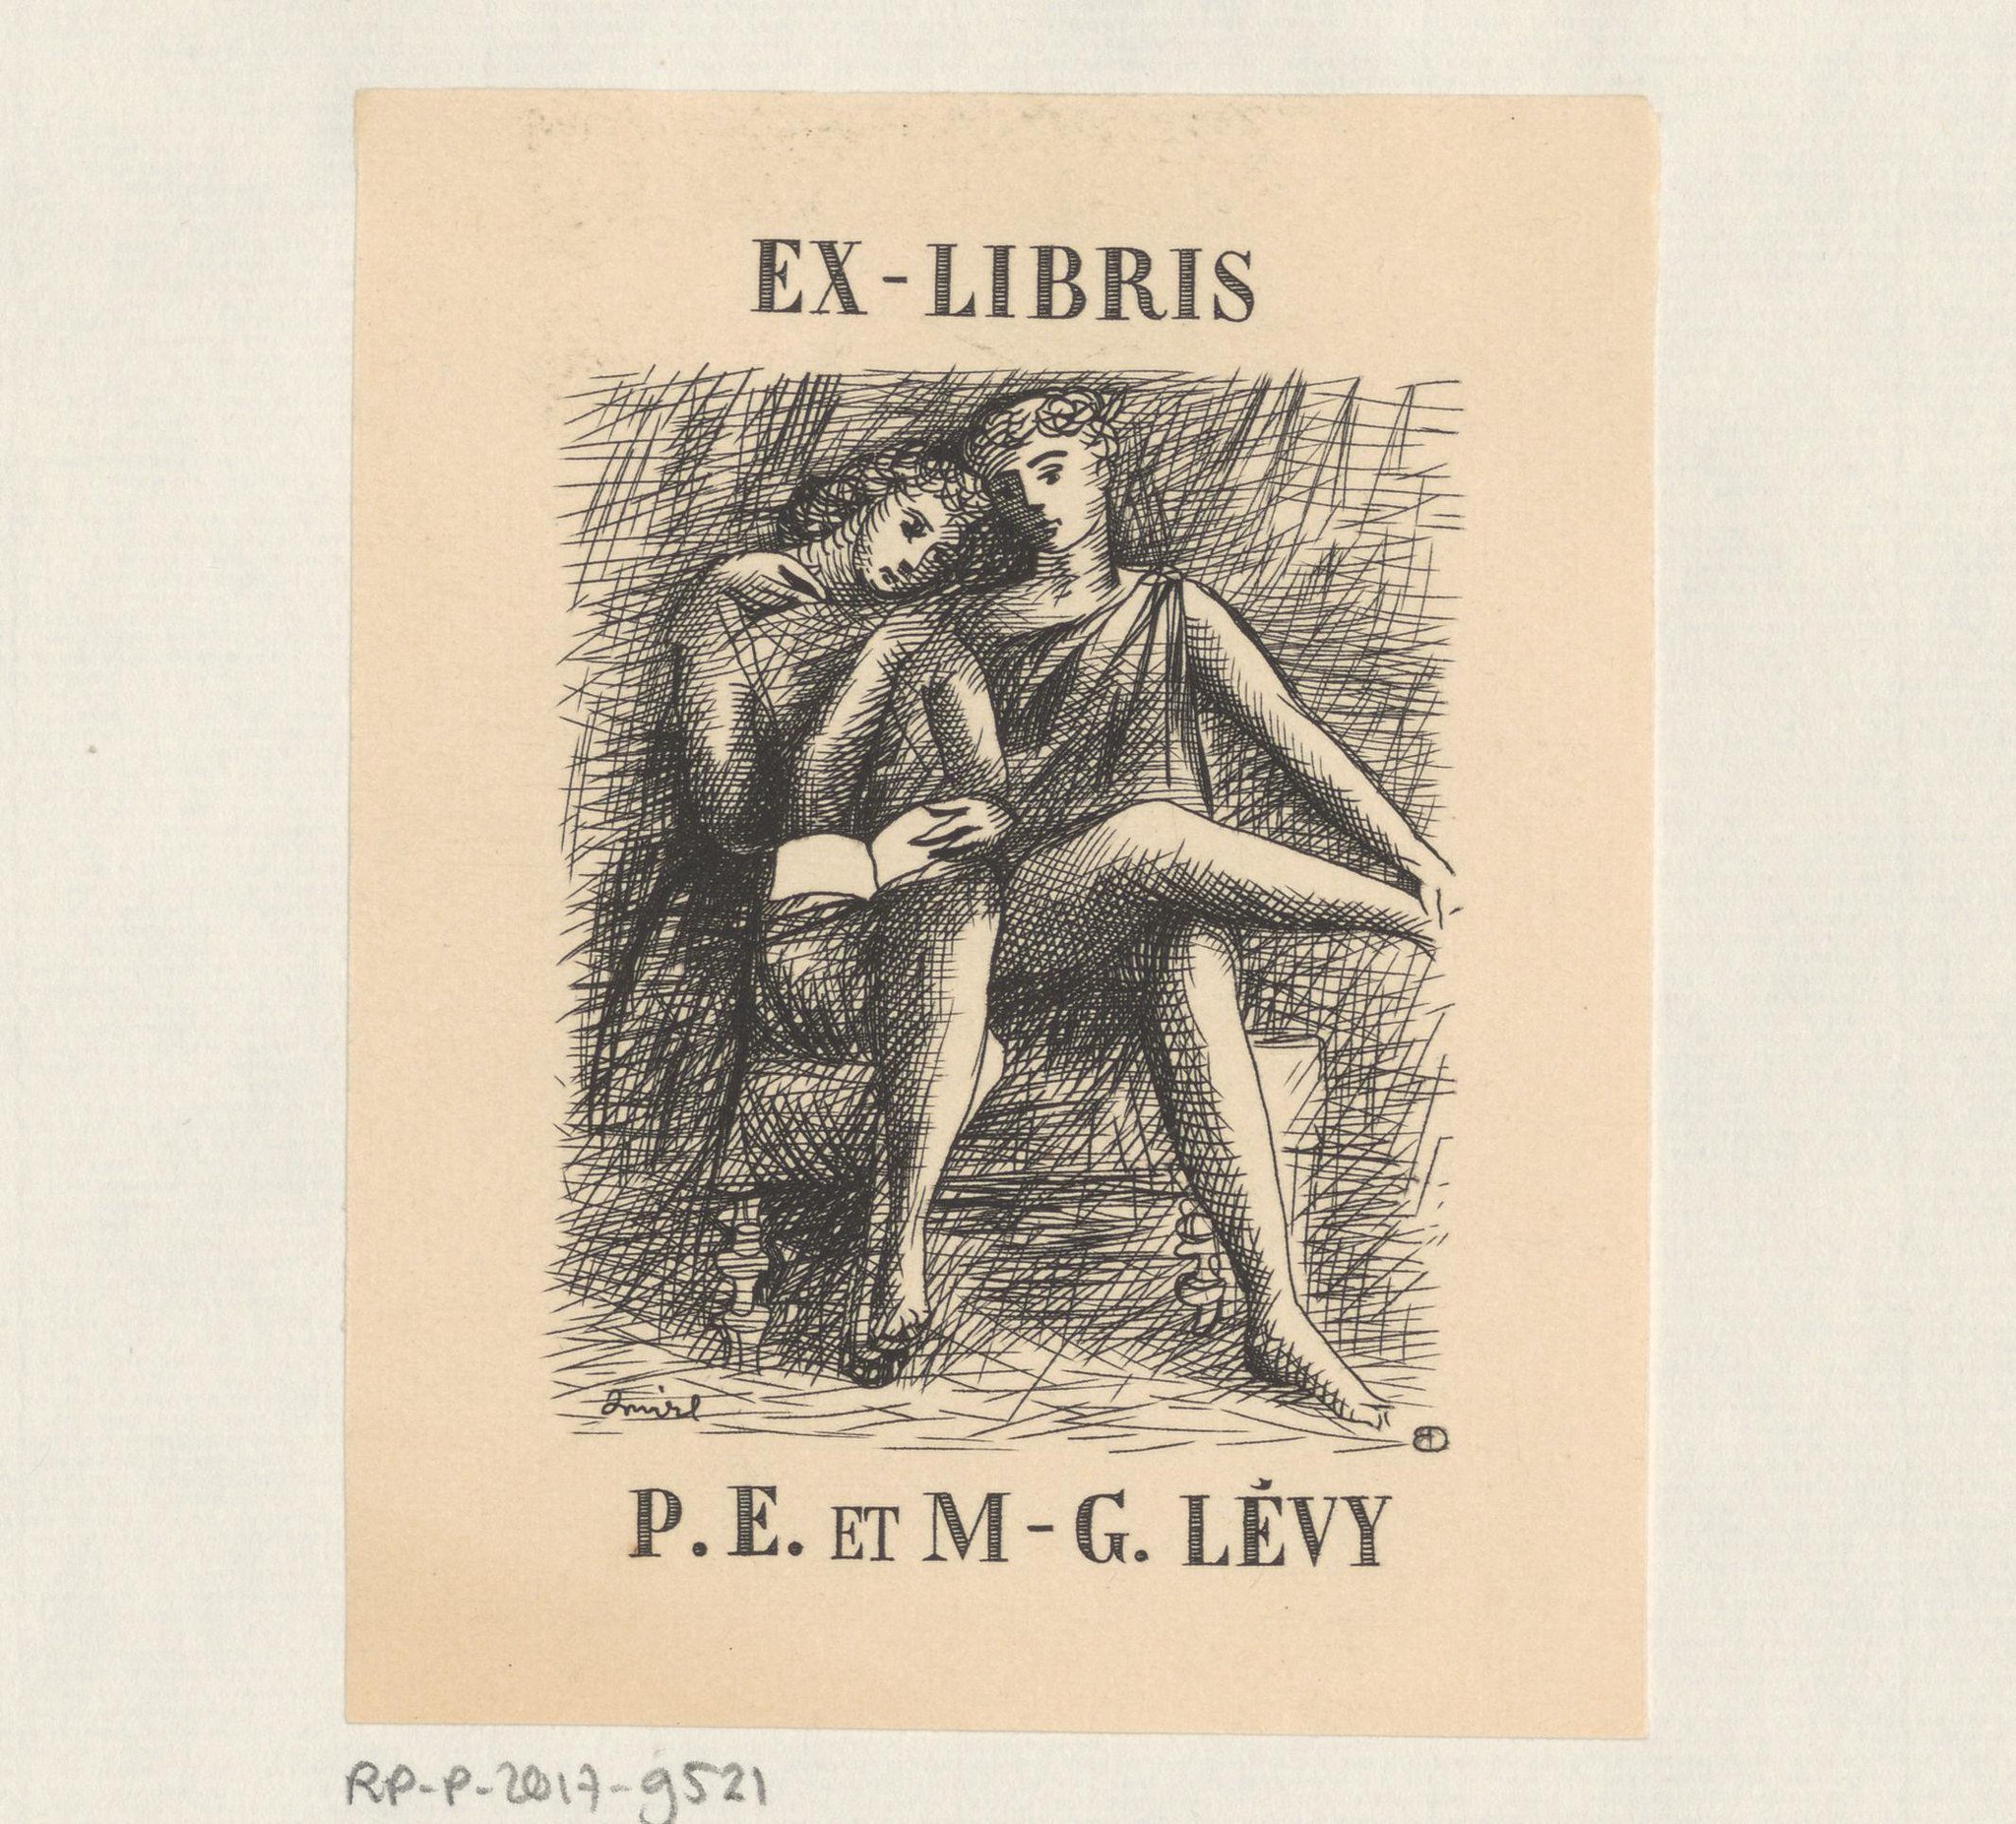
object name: bookplate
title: Ex libris van Pierre-Edmond en Marguerite-Gabrielle Lévy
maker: jacques daniel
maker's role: print maker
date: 1920-1969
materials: paper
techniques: engraving, etching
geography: france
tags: sitting figure, book, couple of lovers